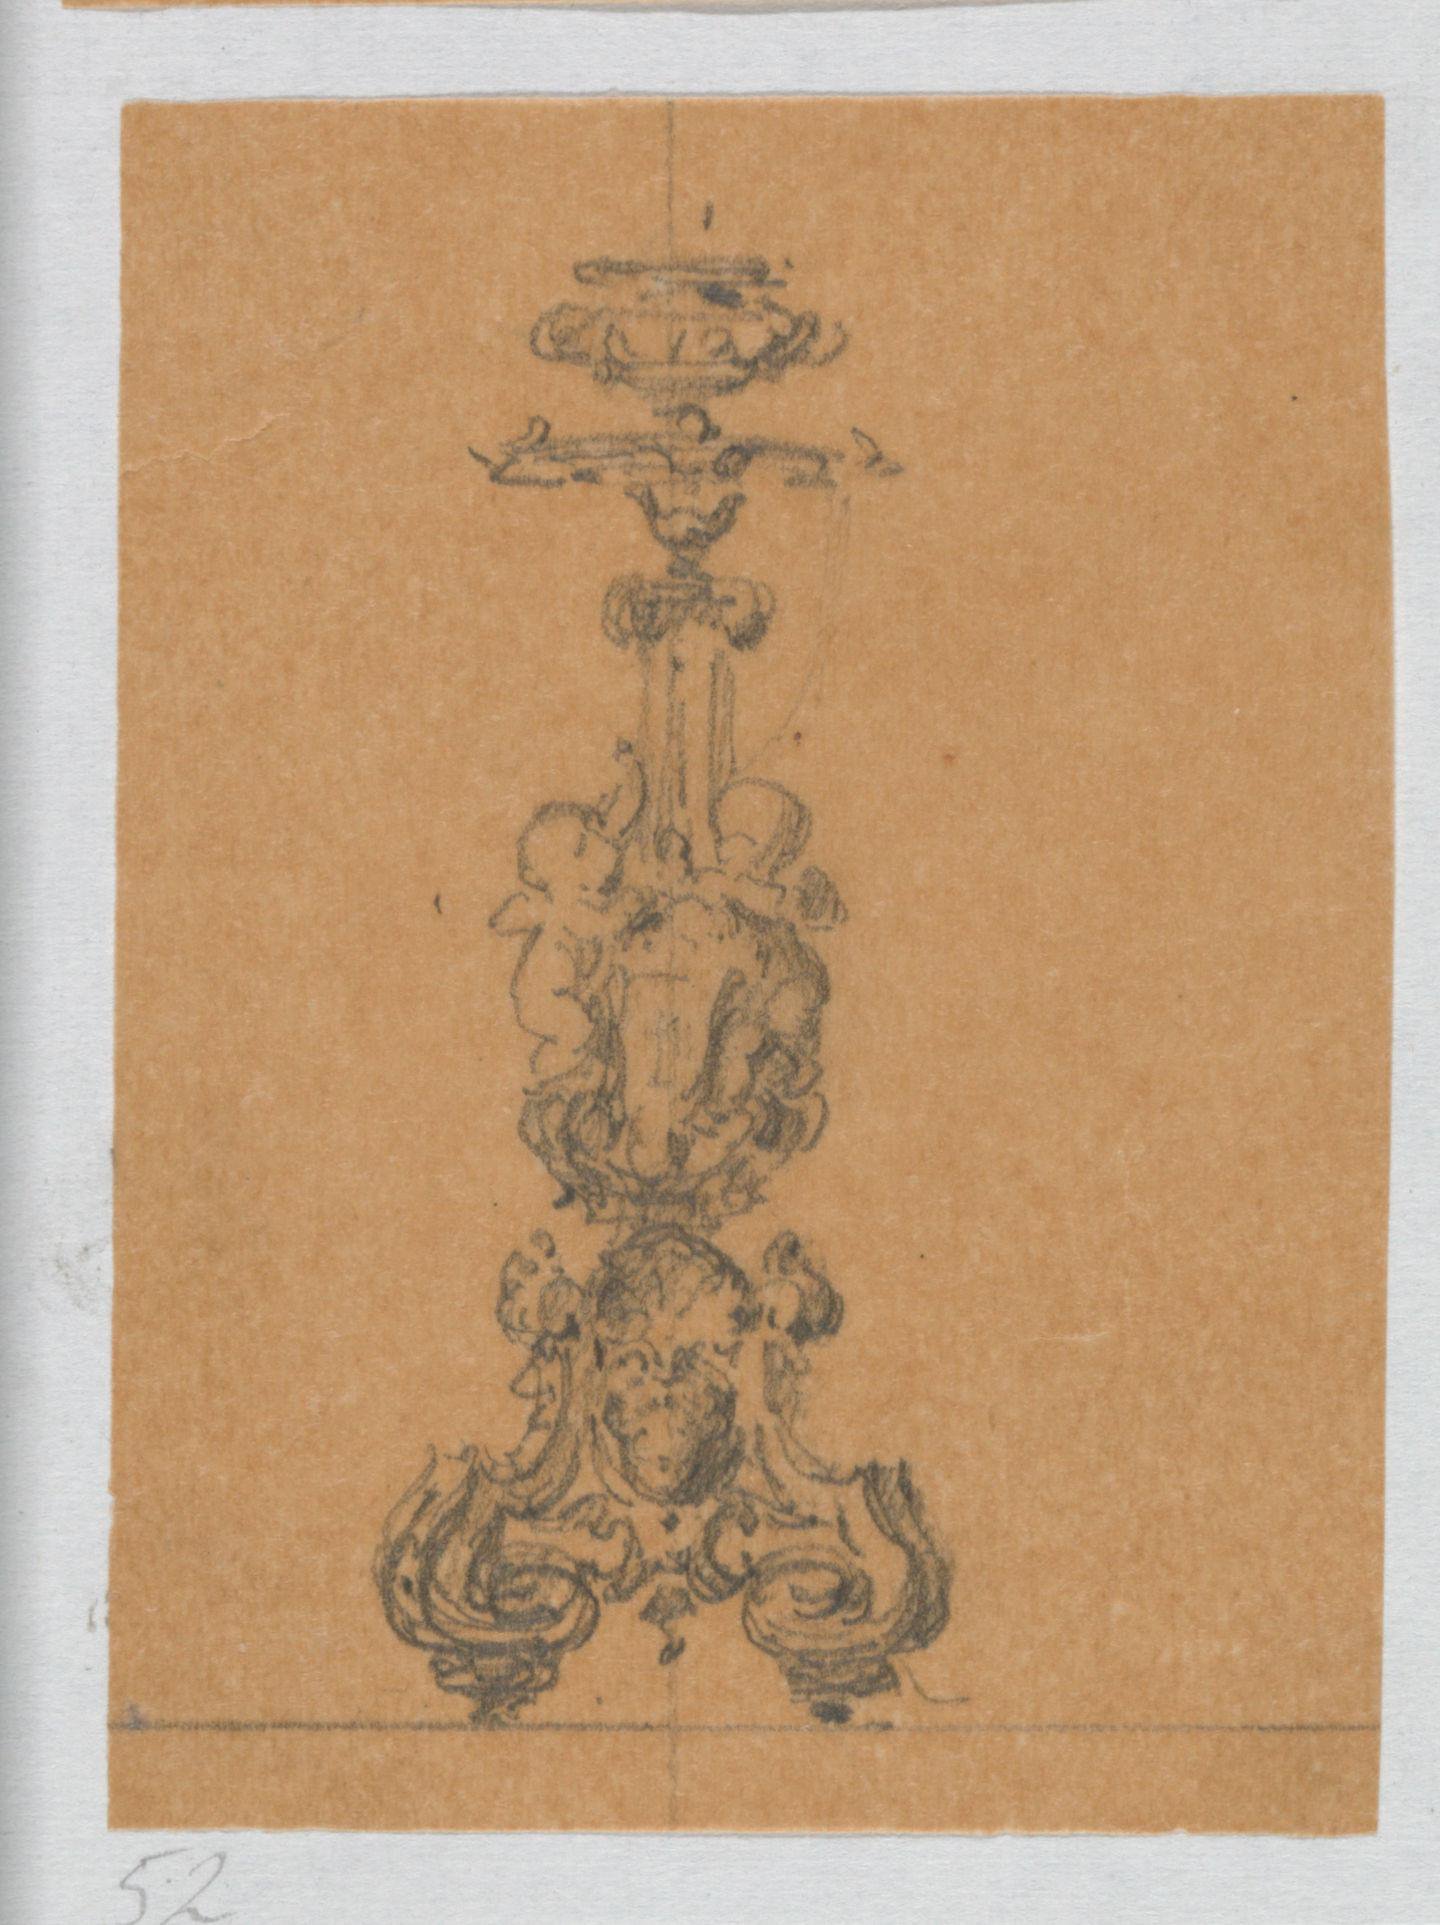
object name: design drawing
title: Ontwerp voor kandelaar met twee putti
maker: henri cameré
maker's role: designer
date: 1864-1894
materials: pencil, paper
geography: paris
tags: chandelier, candelabrum